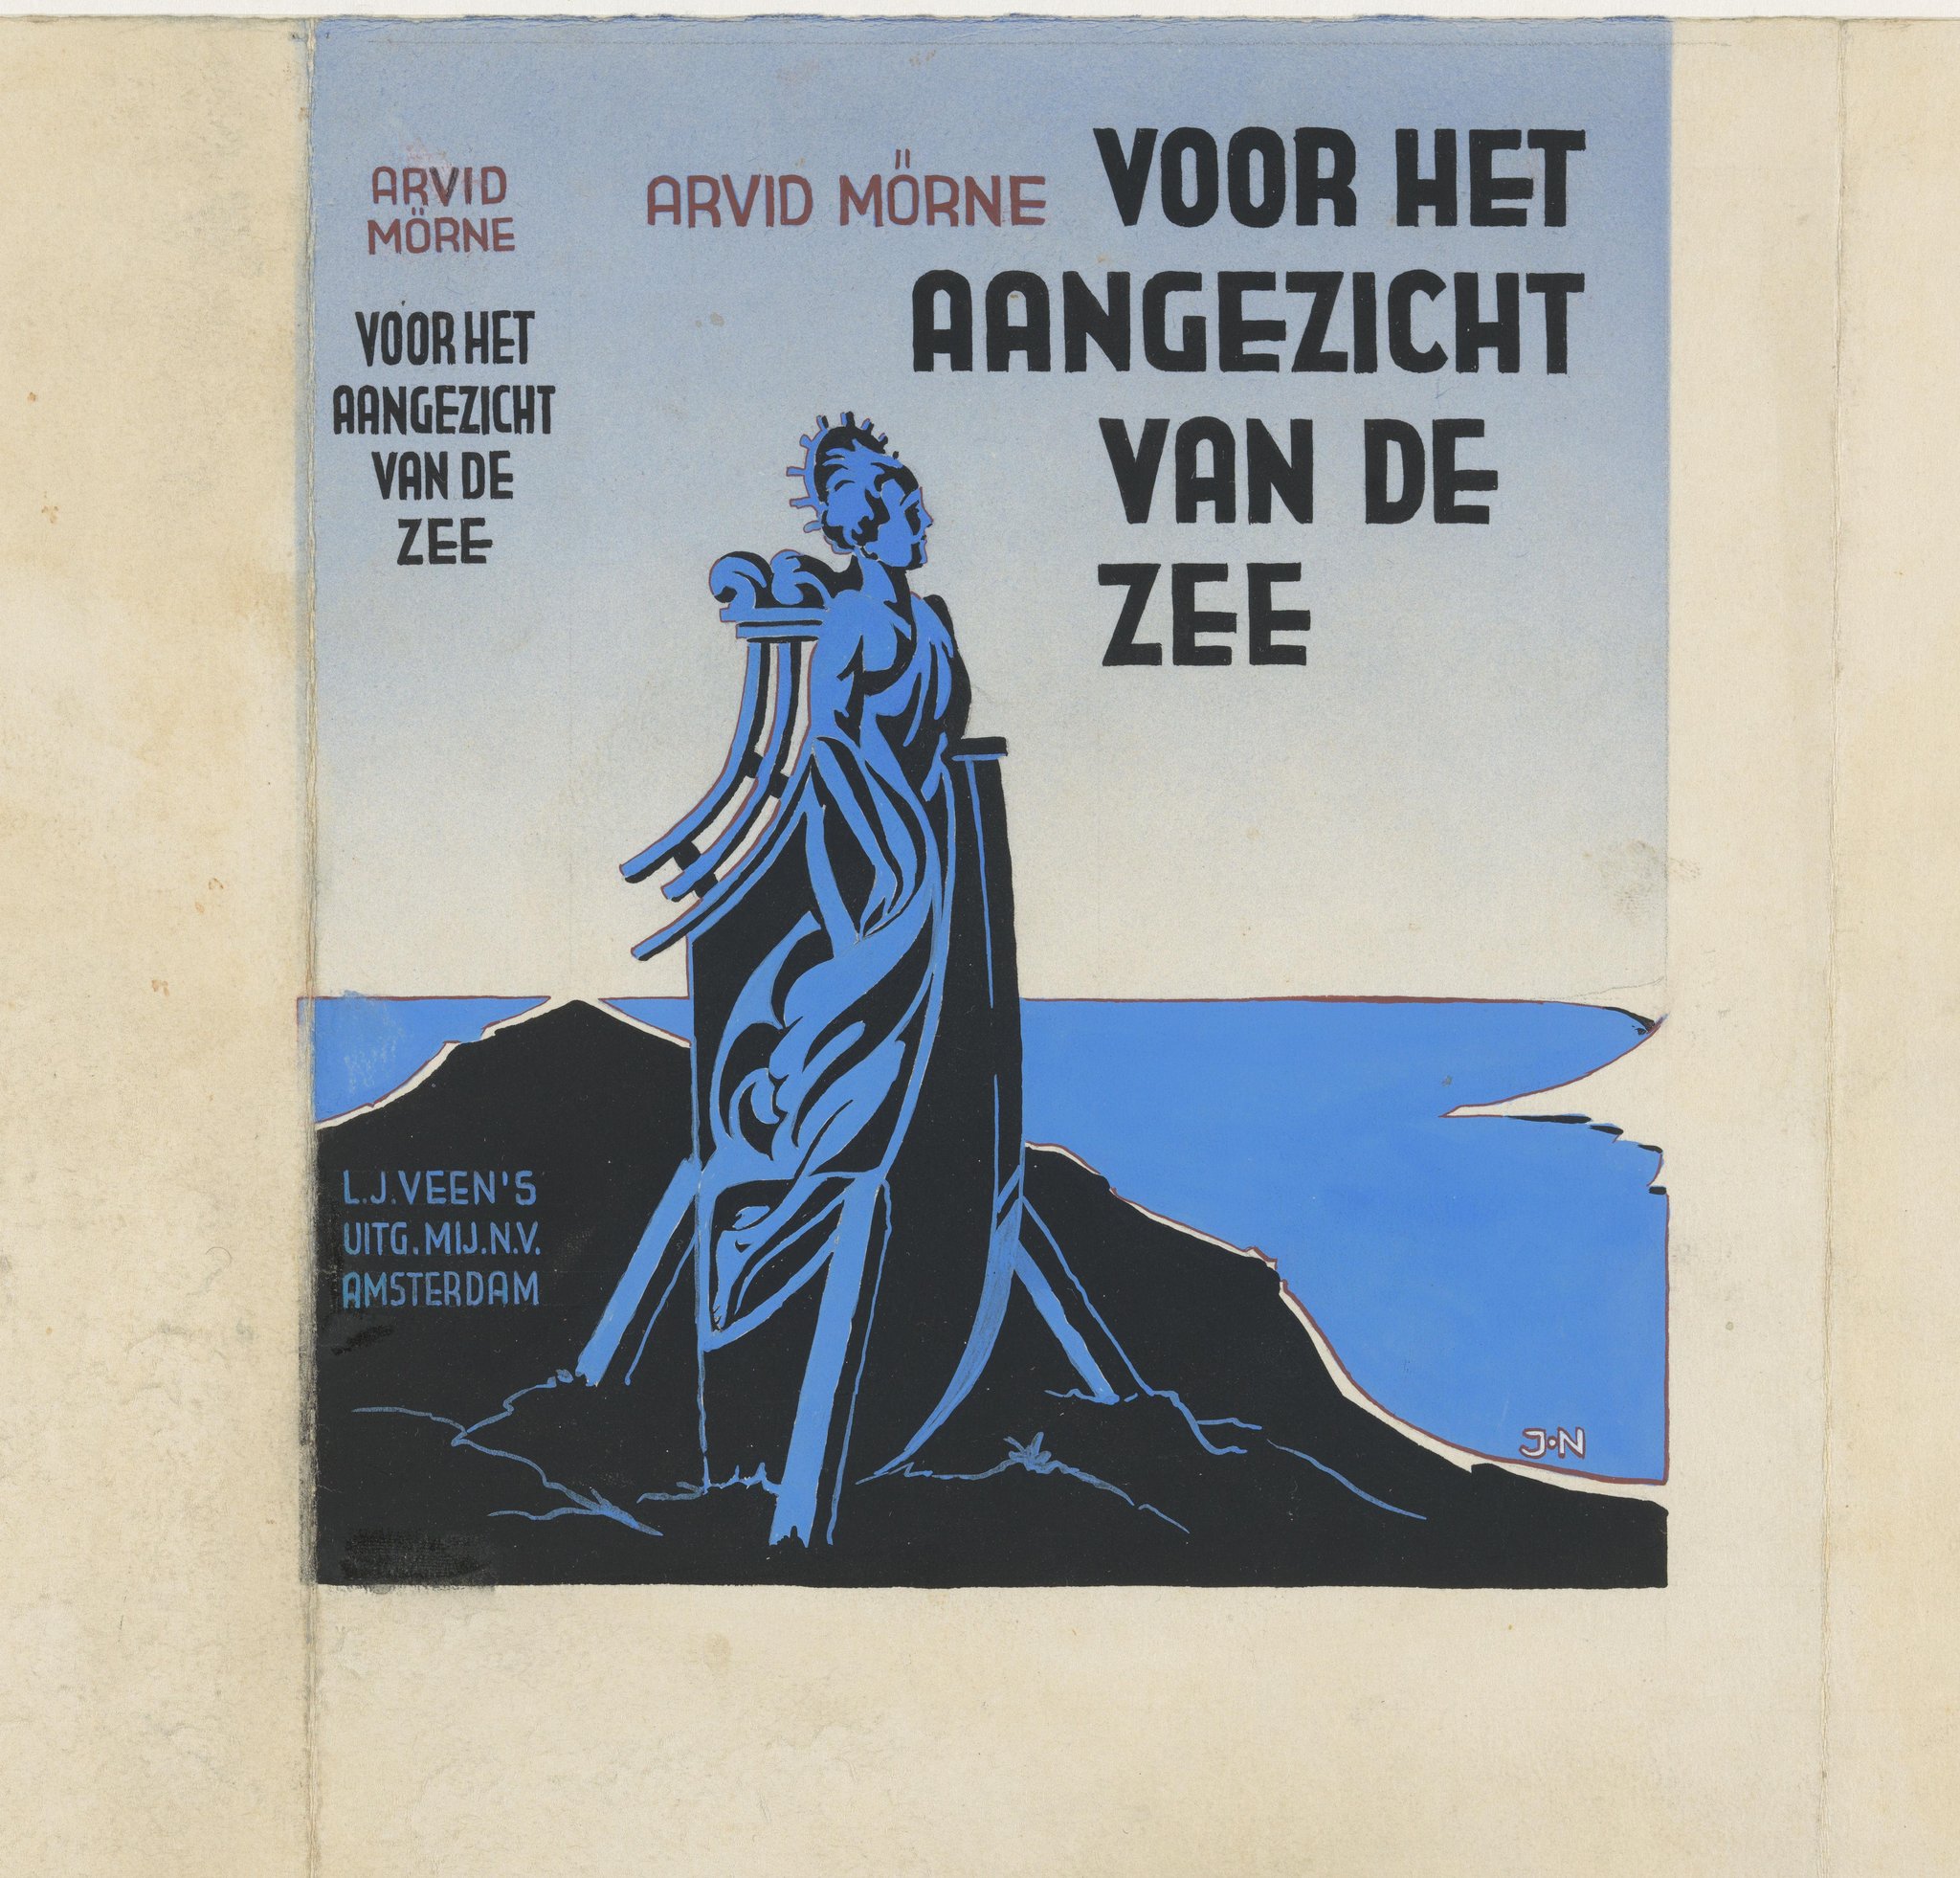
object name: drawing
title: Bandontwerp voor: Arvid Mörne, Voor het aangezicht van de zee (Inför havets anlete), 1938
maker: jac nuiver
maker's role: grafisch ontwerper, illustrator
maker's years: 1892-1953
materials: paint, paper, pencil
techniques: brush, pen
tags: monument, statue, sea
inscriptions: signature: ‘J.N’, :, collector's mark: Lugt 2228a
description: Sculptuur van een vrouwfiguur bovenop een rots. In de achtergrond de zee.